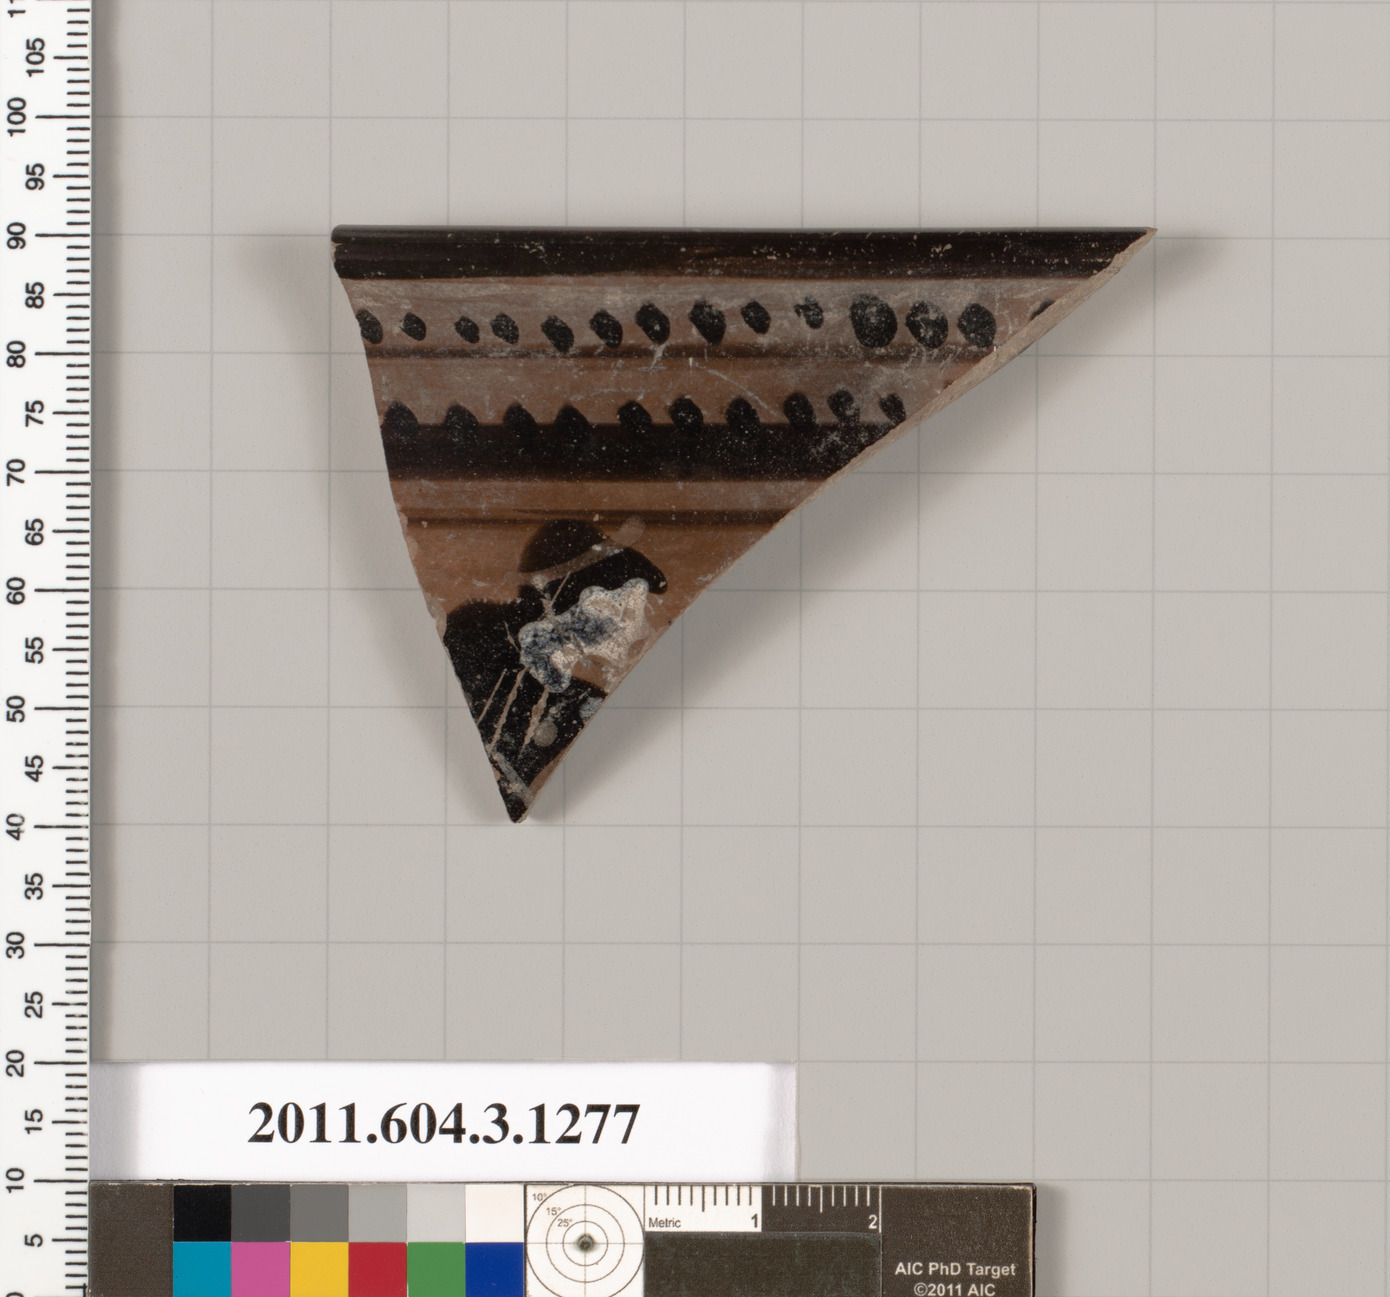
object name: skyphos fragment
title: Terracotta rim fragment of a skyphos (deep drinking cup)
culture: greek, attic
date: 500 BCE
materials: terracotta